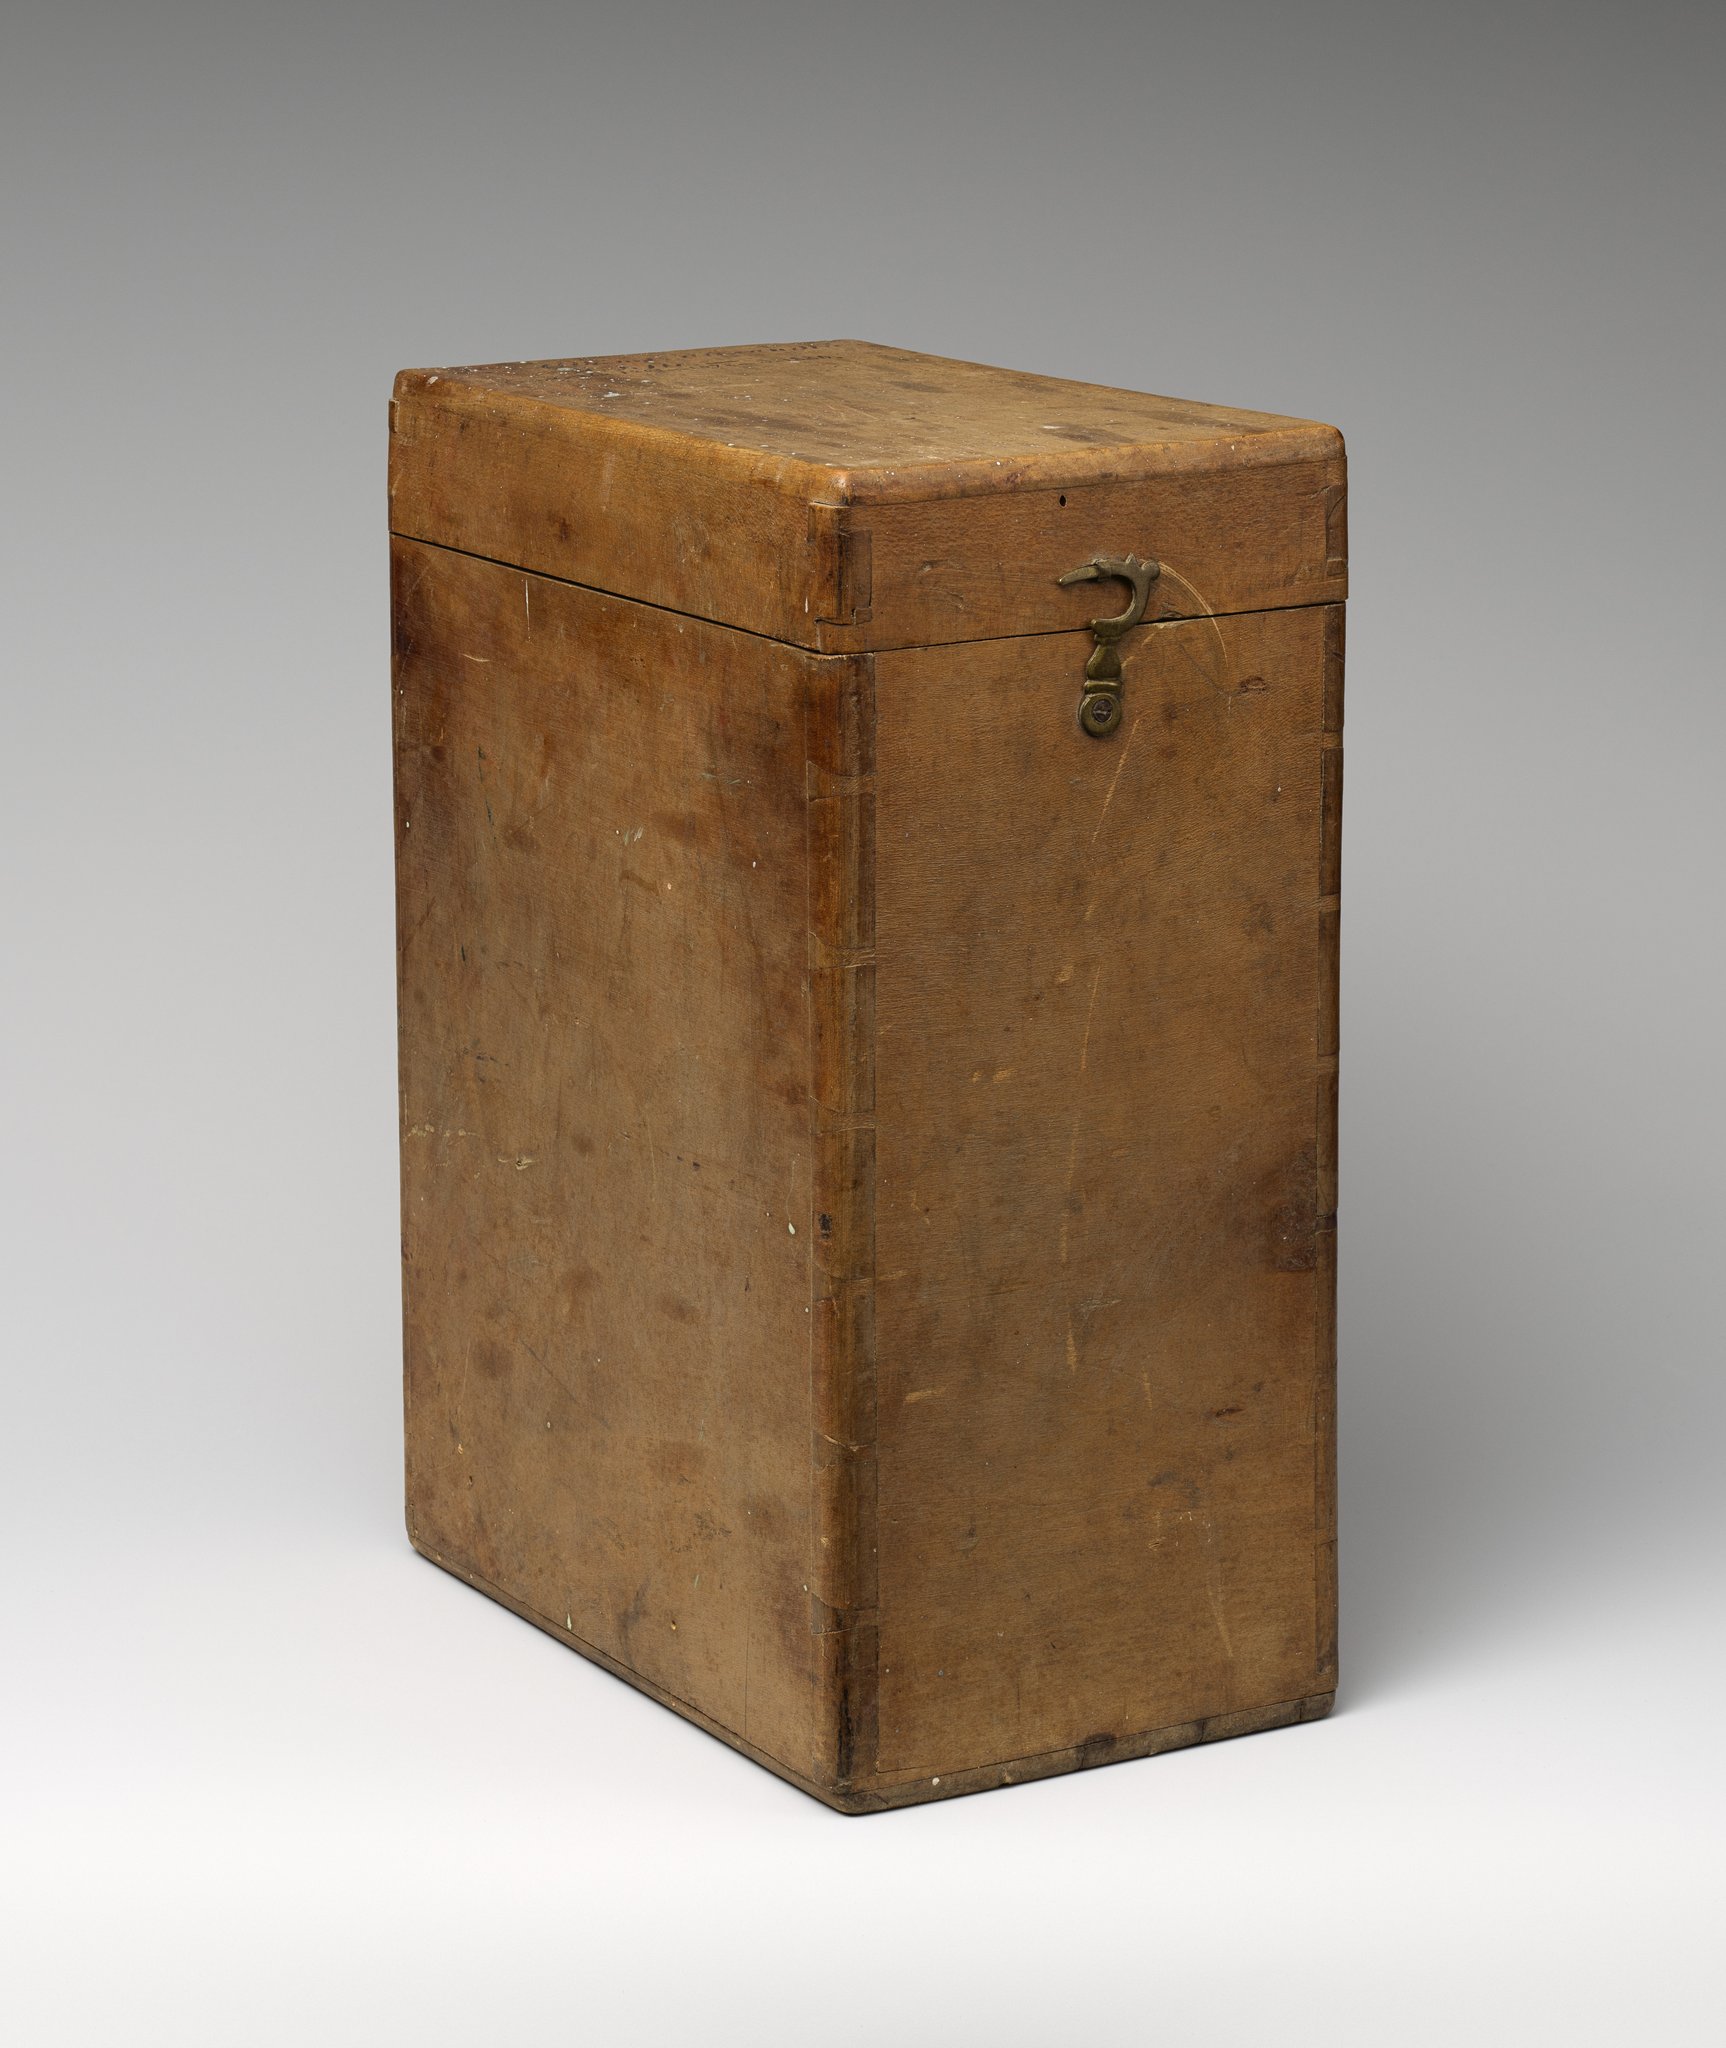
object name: box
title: [Daguerreotype Plate Box]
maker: Anonymous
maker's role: maker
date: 1840-1849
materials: ink, iron, wood